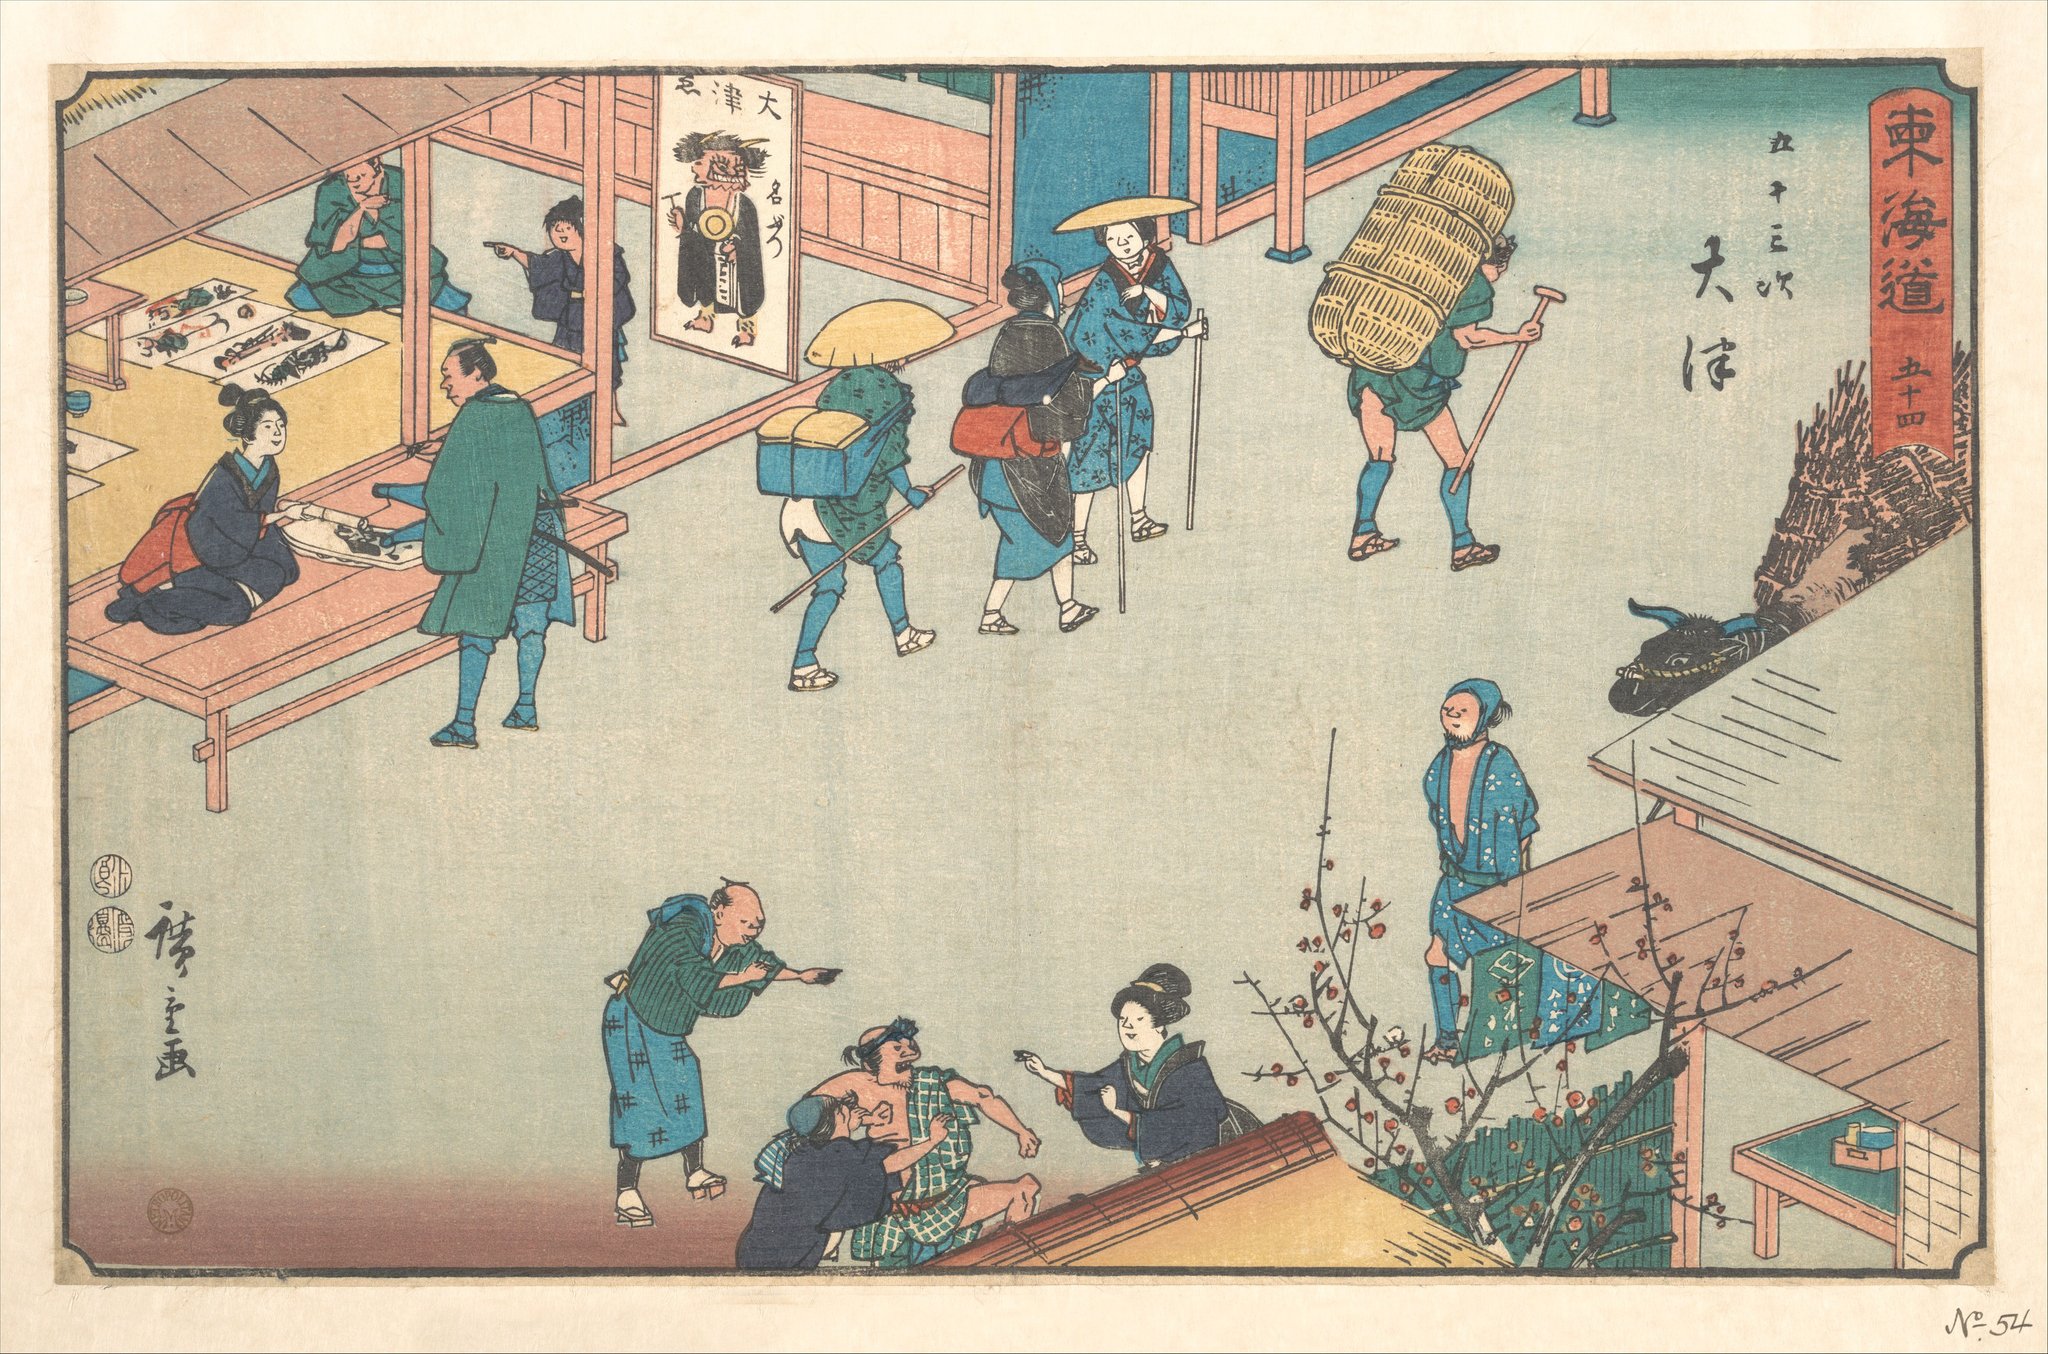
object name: print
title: Otsu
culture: japanese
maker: utagawa hiroshige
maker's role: artist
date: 1840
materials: ink, paper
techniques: woodblock print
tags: men,women,street scene,markets